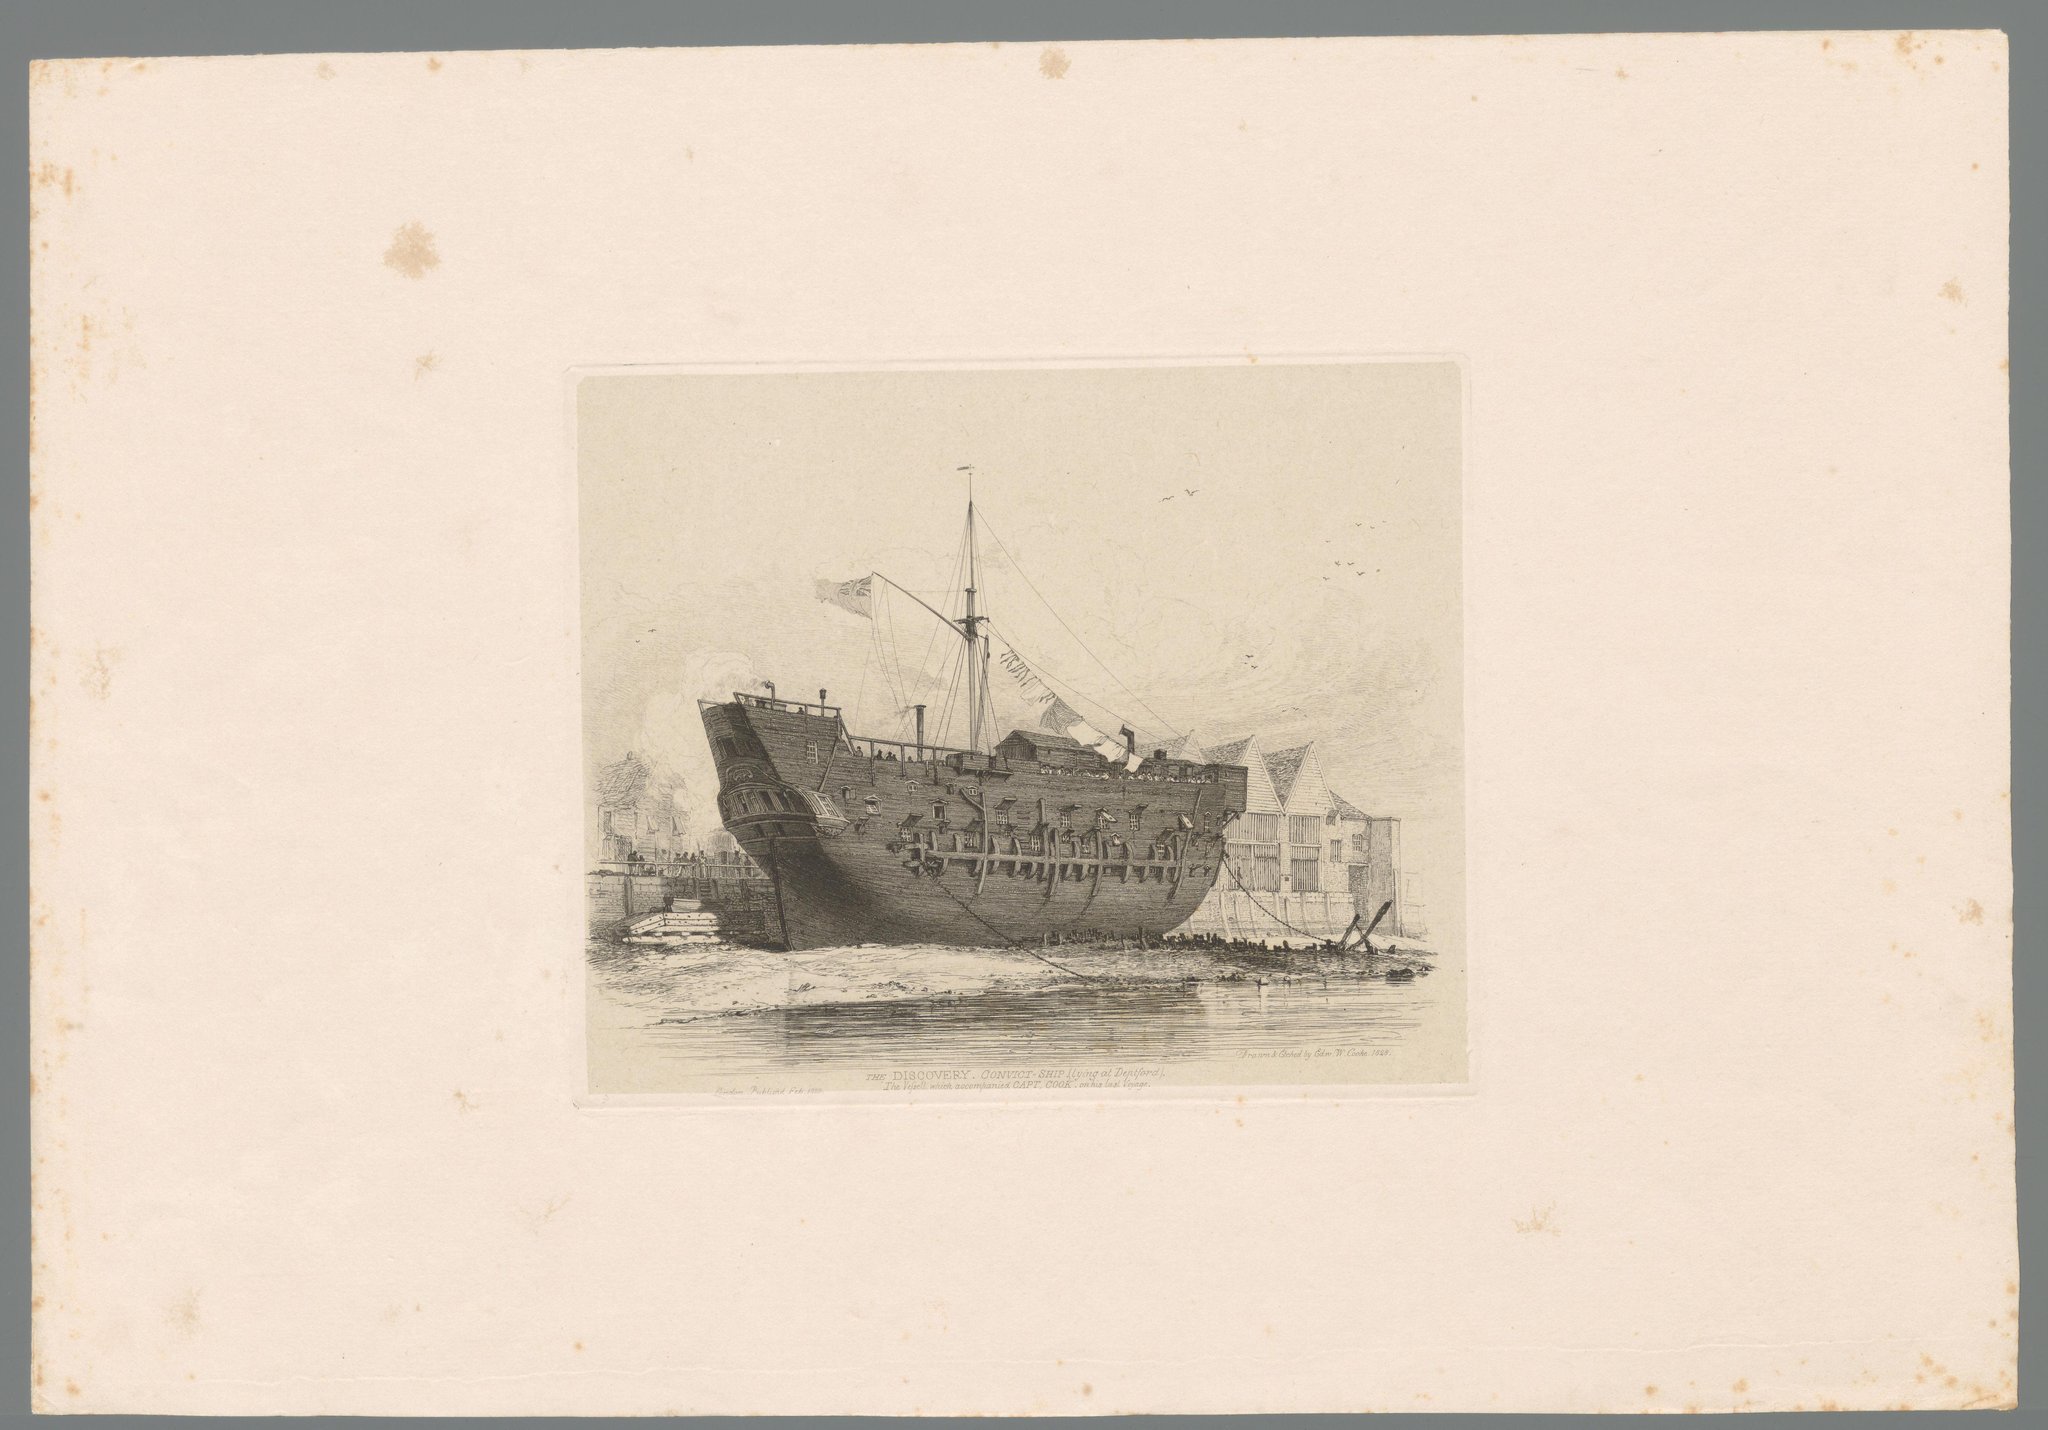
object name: print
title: Schip liggend op de oever bij Deptford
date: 1828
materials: paper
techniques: etching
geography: london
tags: ships (in general), deptford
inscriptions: collector's mark: Lugt 2165